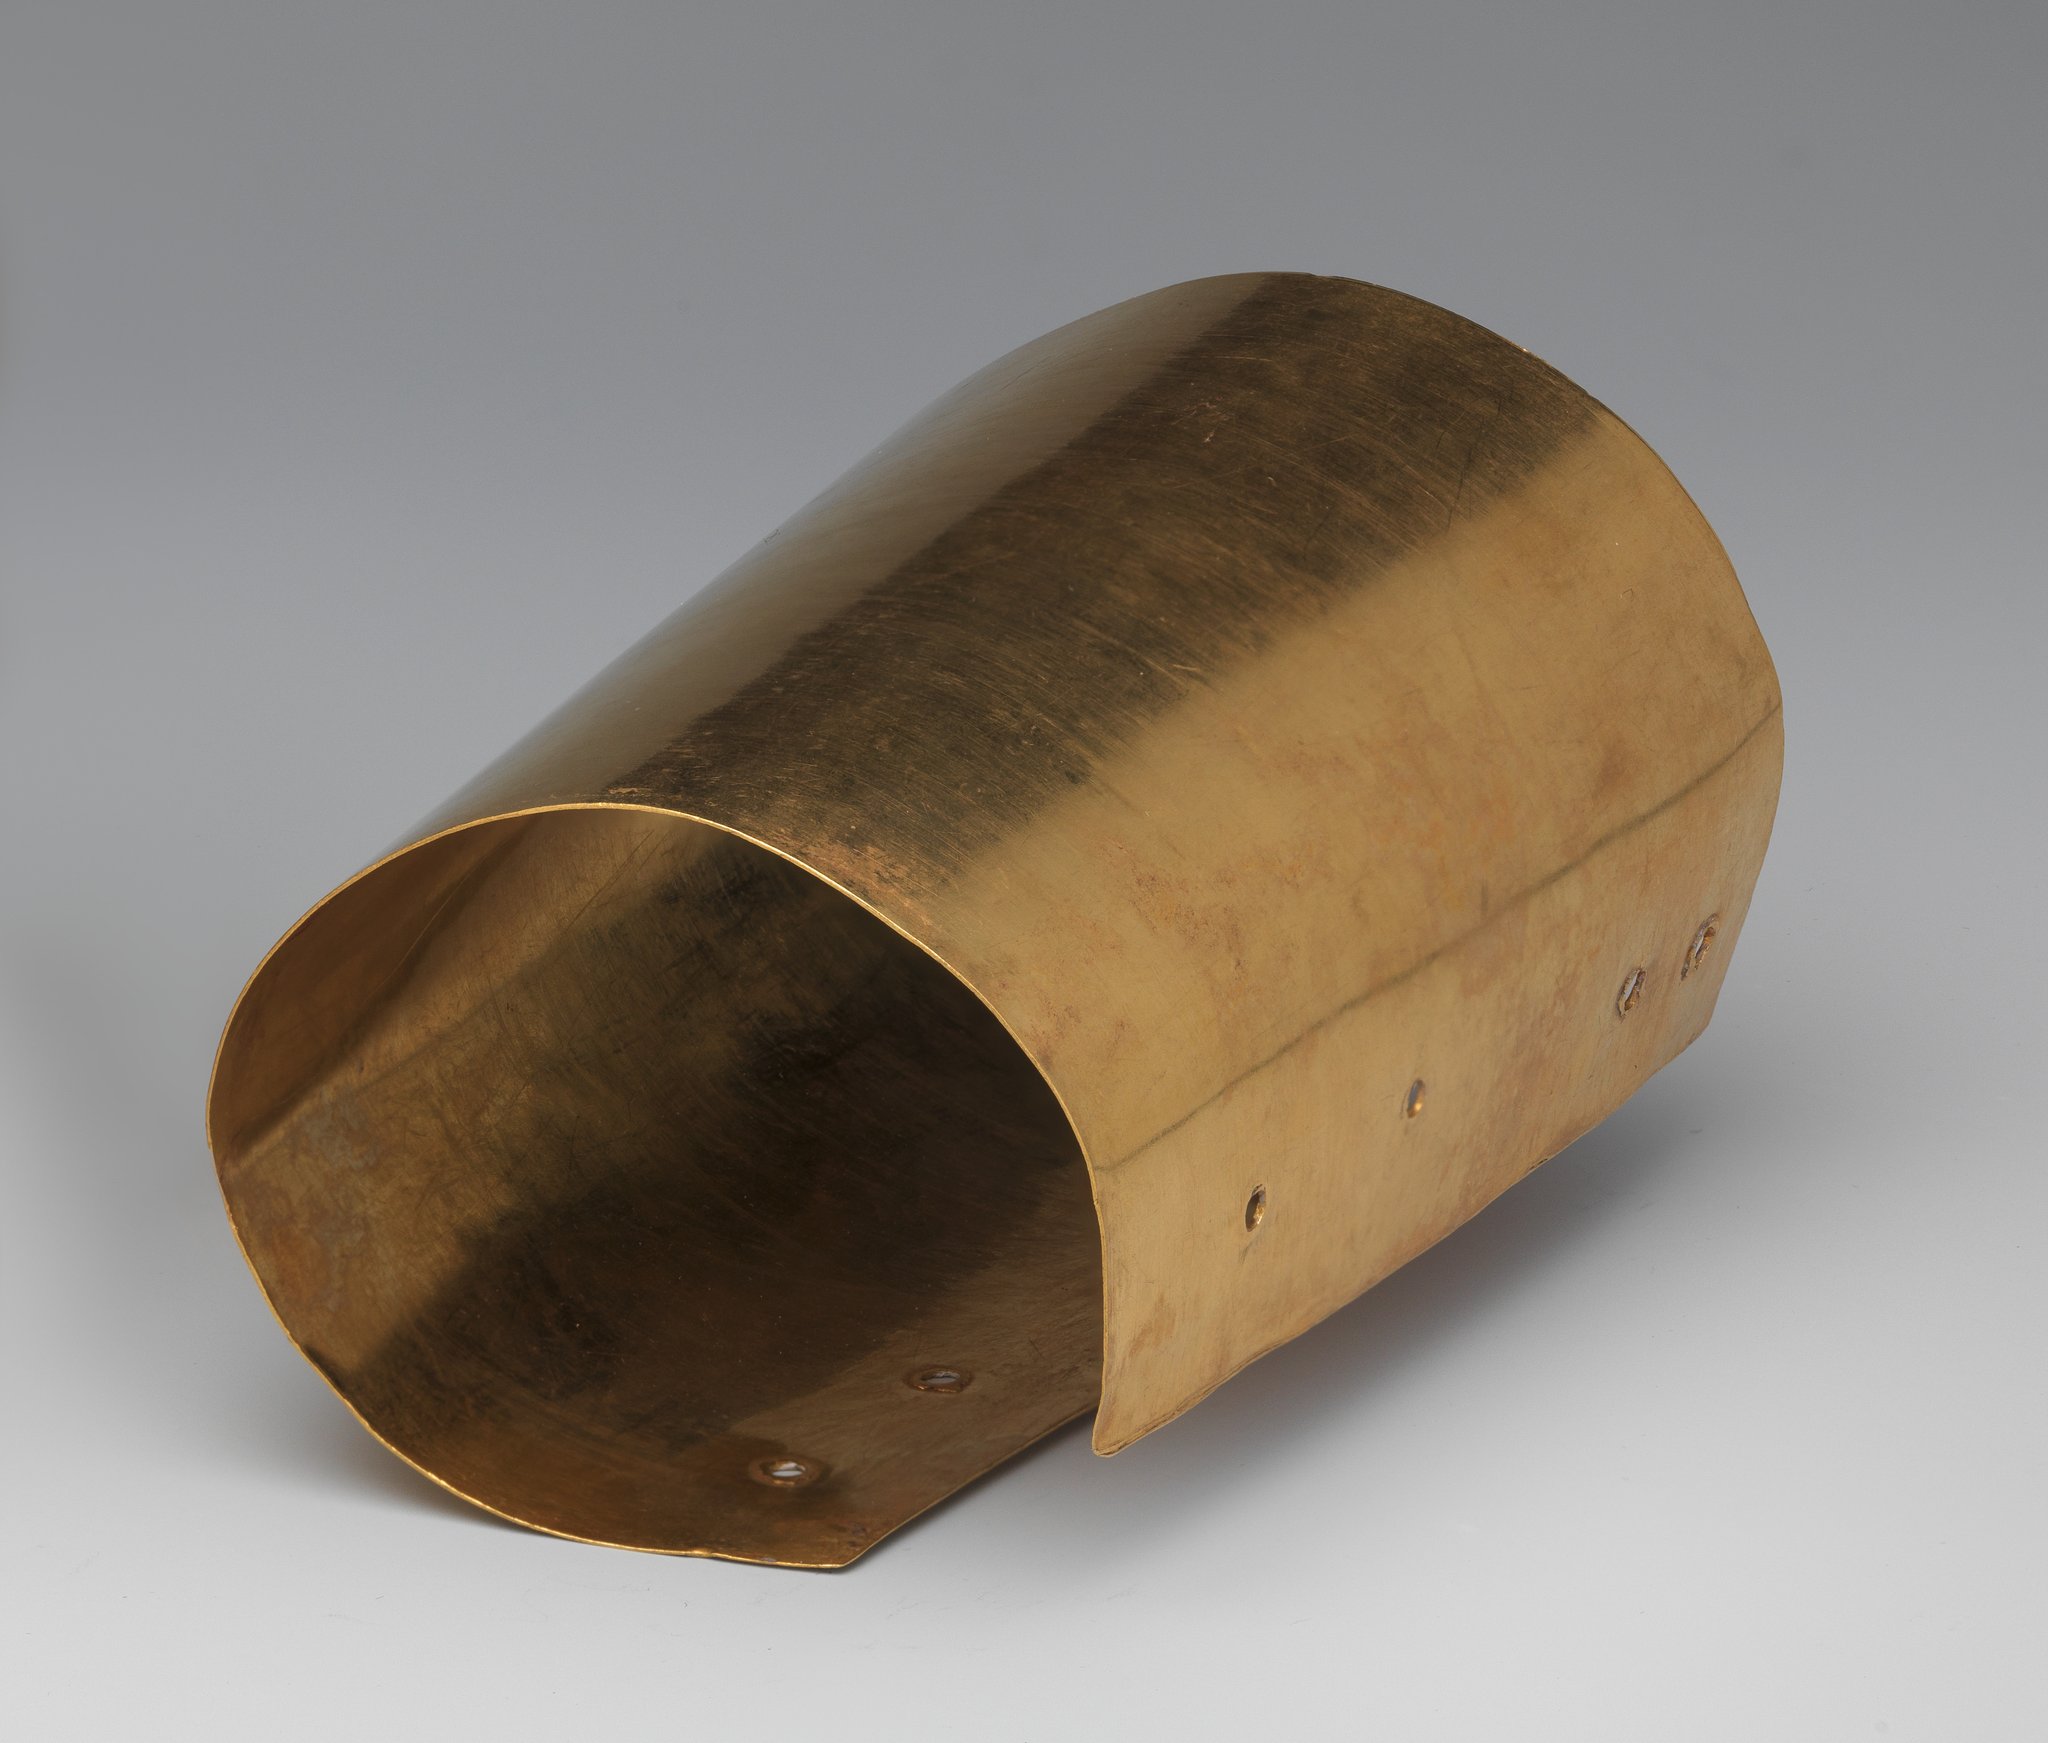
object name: arm band, one of a pair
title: Cuff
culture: conte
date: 501-1200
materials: gold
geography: panama